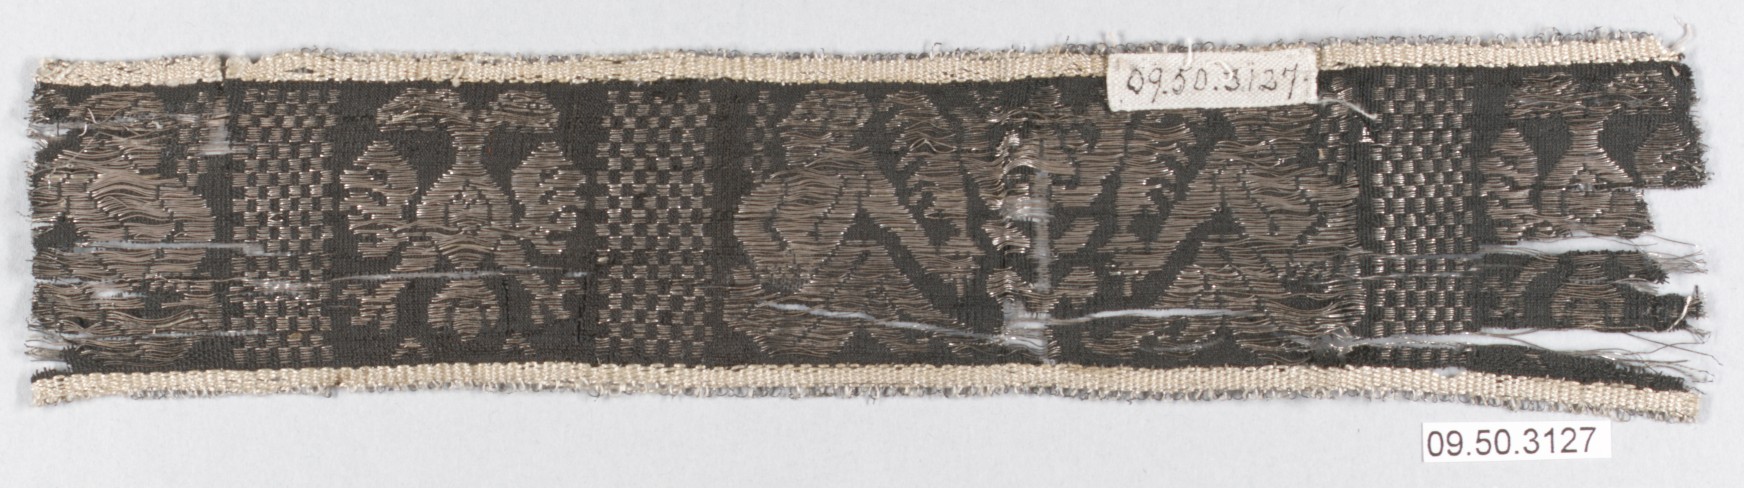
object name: galloon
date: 1701-1800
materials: metal thread, silk